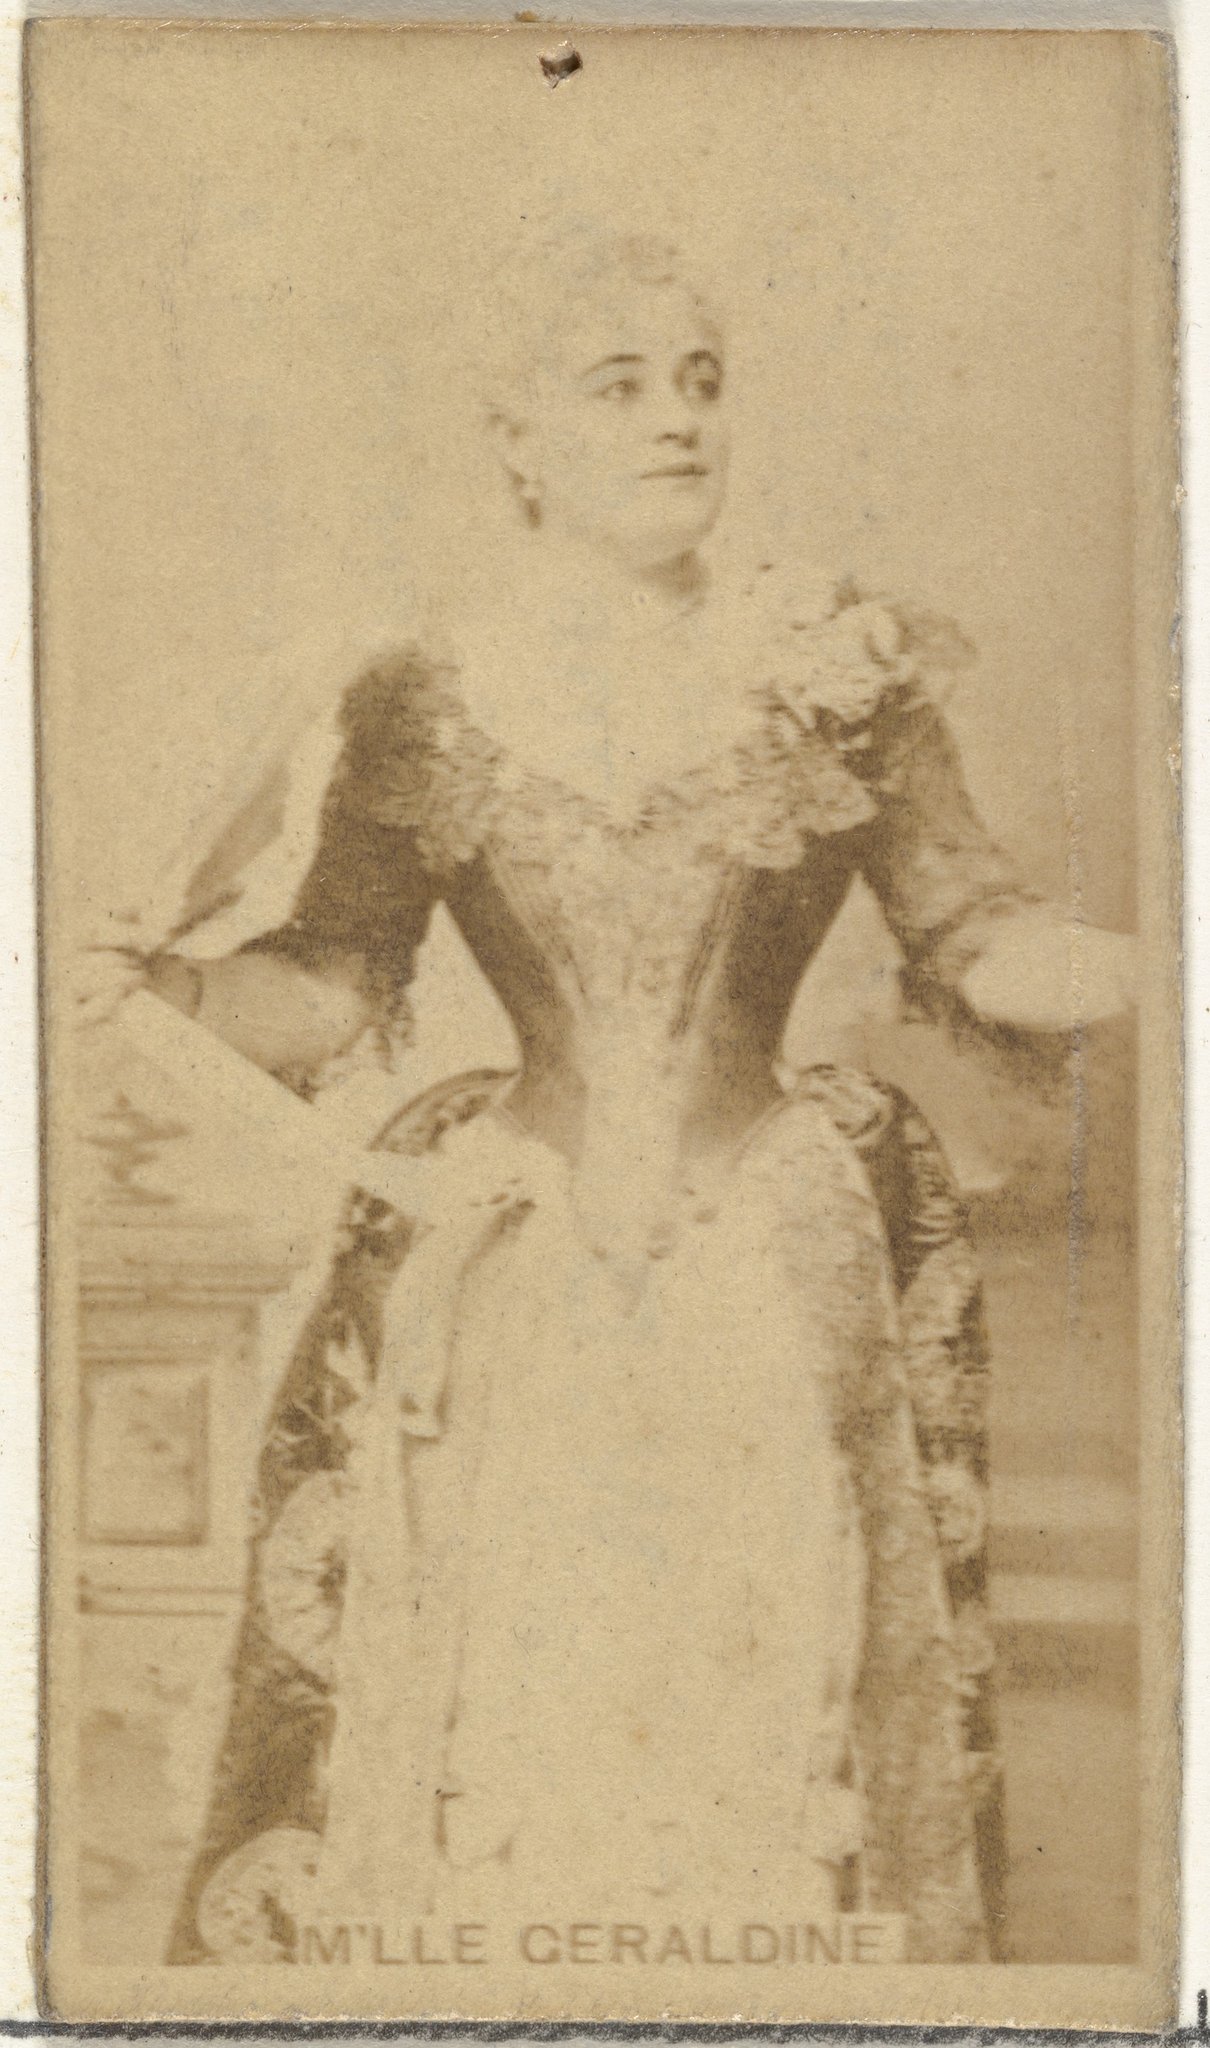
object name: photograph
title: M'lle Geraldine, from the Actors and Actresses series (N145-8) issued by Duke Sons & Co. to promote Duke Cigarettes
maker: w. duke, sons & co.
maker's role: publisher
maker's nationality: american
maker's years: 1870-1920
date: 1891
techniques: albumen silver print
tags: portraits,women,actresses